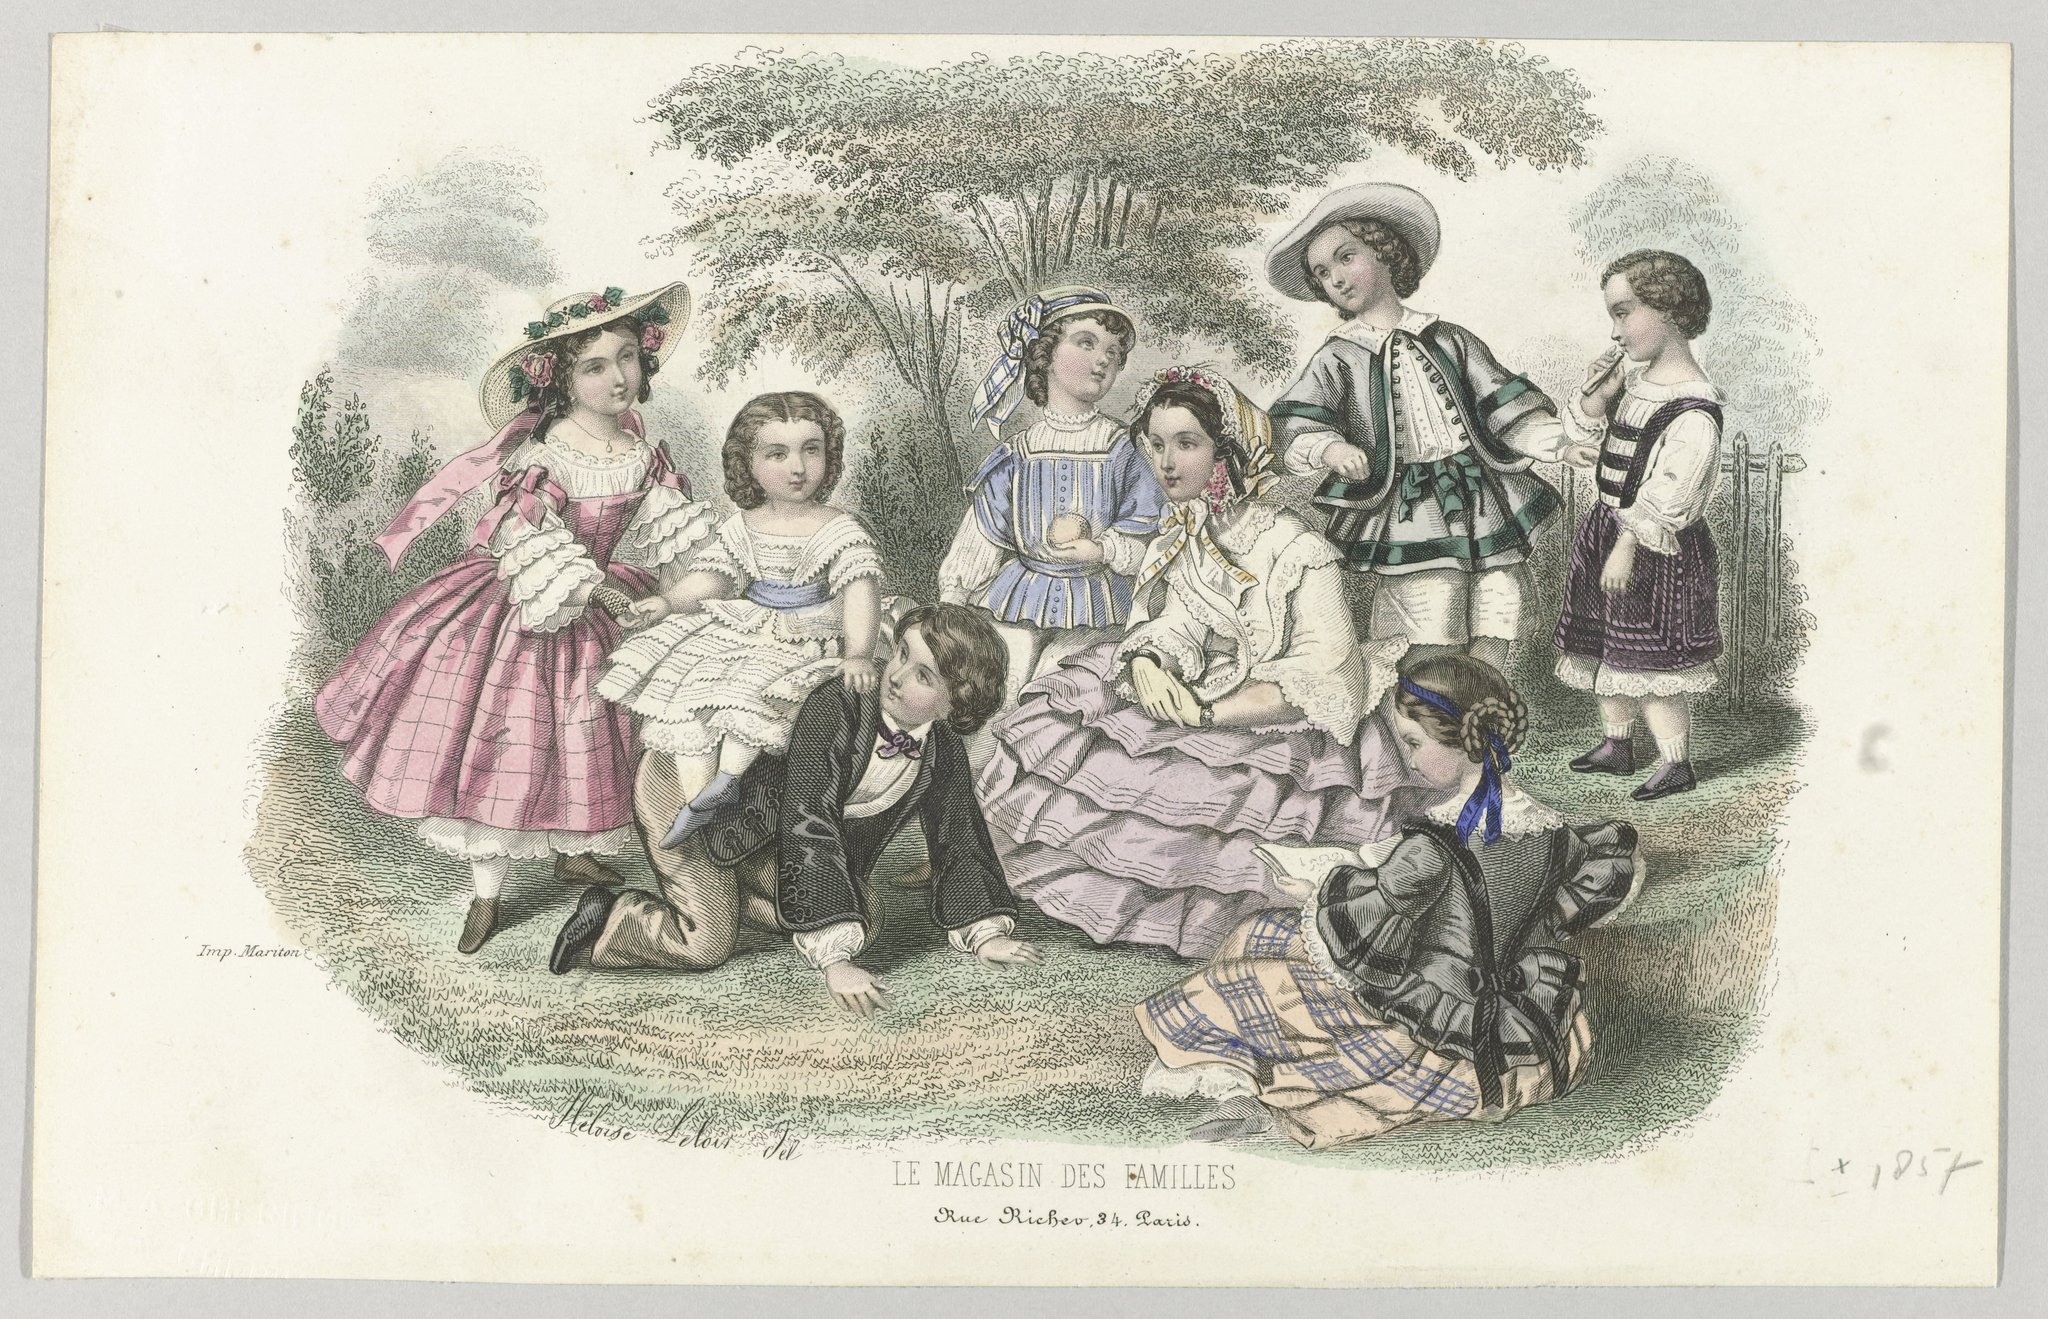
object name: fashion print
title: Le Magasin des Familles, ca. 1857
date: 1857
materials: paper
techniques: engraving, hand coloring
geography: paris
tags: clothes, costume (+ girls' clothes), pick-a-back, piggyback, clothes, costume (+ boys' clothes), fashion plates, book - mm - book open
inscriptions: address: ‘Rue Richer, 34, Paris.’, title: ‘Le Magasin des Familles’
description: Kinderkleding: vier meisjes en vier jongens van verschillende leeftijden in een park. Een meisje zit op de rug van een jongen, die over de grond kruipt. Prent uit het modetijdschrift Le Magasin des Familles (sept. 1849 - juli 1878).